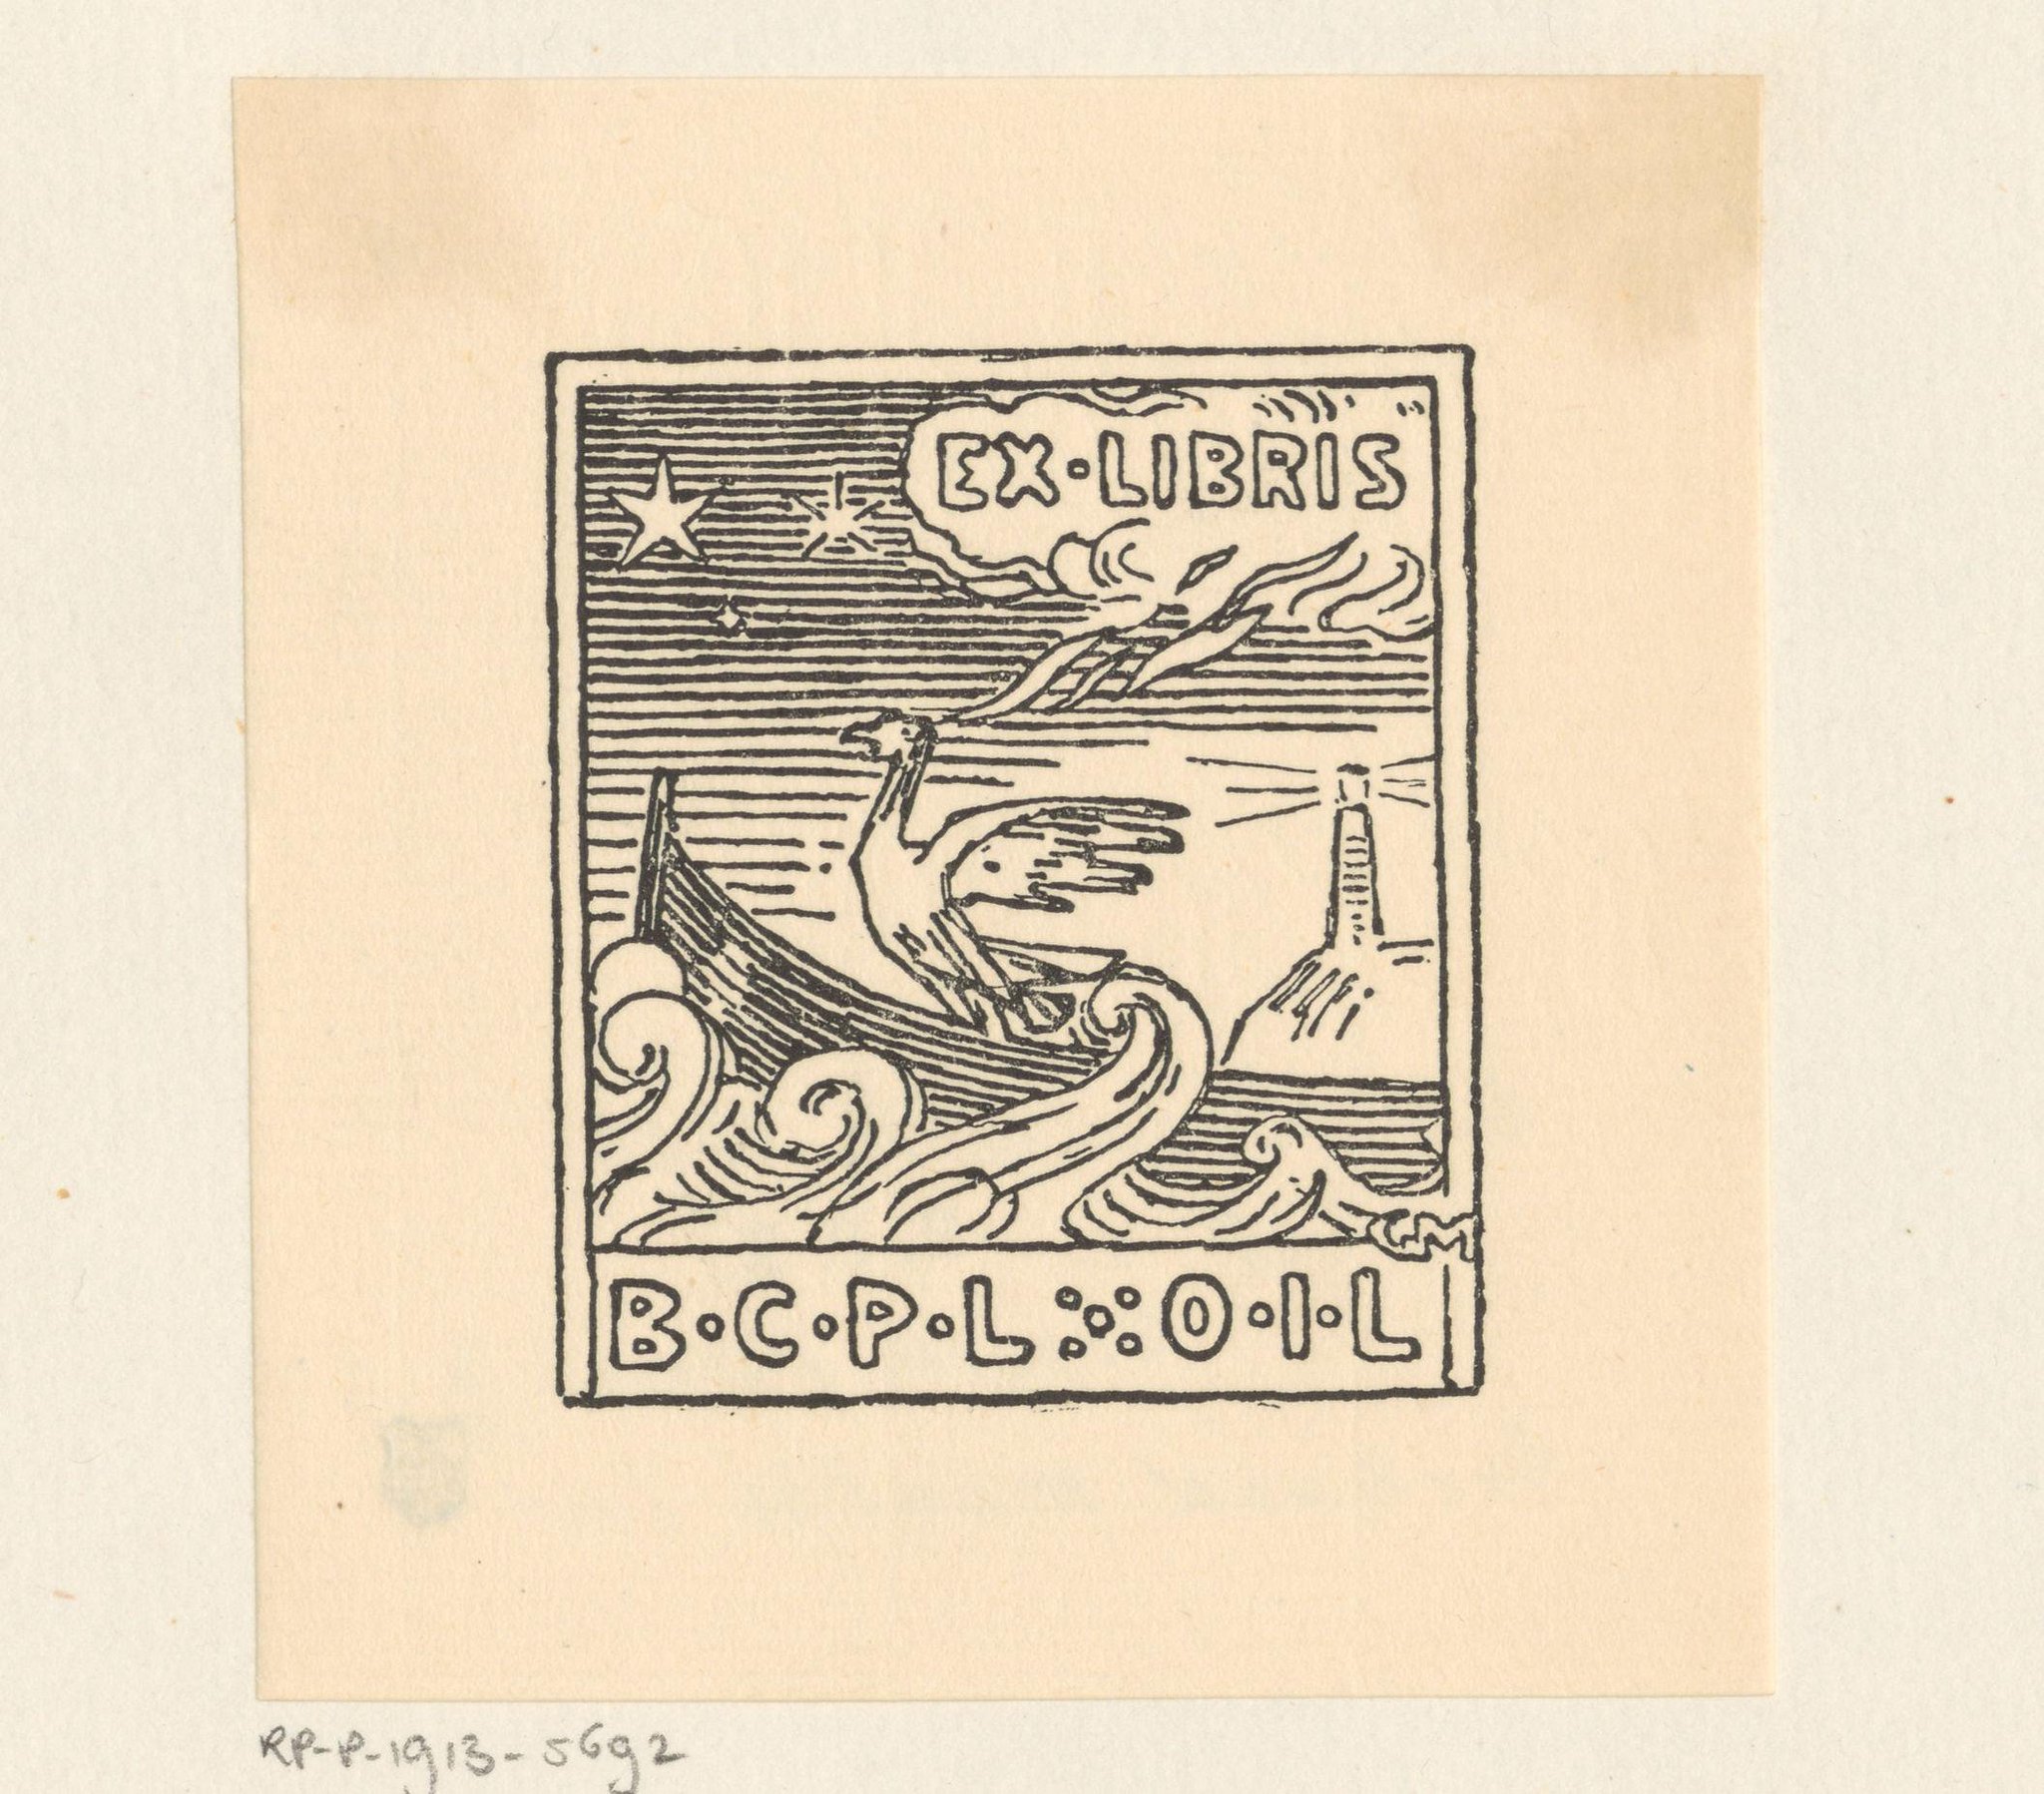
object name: bookplate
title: Ex libris van B.C.P.L. en O.I.L.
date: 1859-1904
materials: paper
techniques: printing block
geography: norway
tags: lighthouse, lightship, wave, birds, ships (in general), stars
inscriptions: collector's mark: Lugt 2233, collector's mark: Lugt 2760